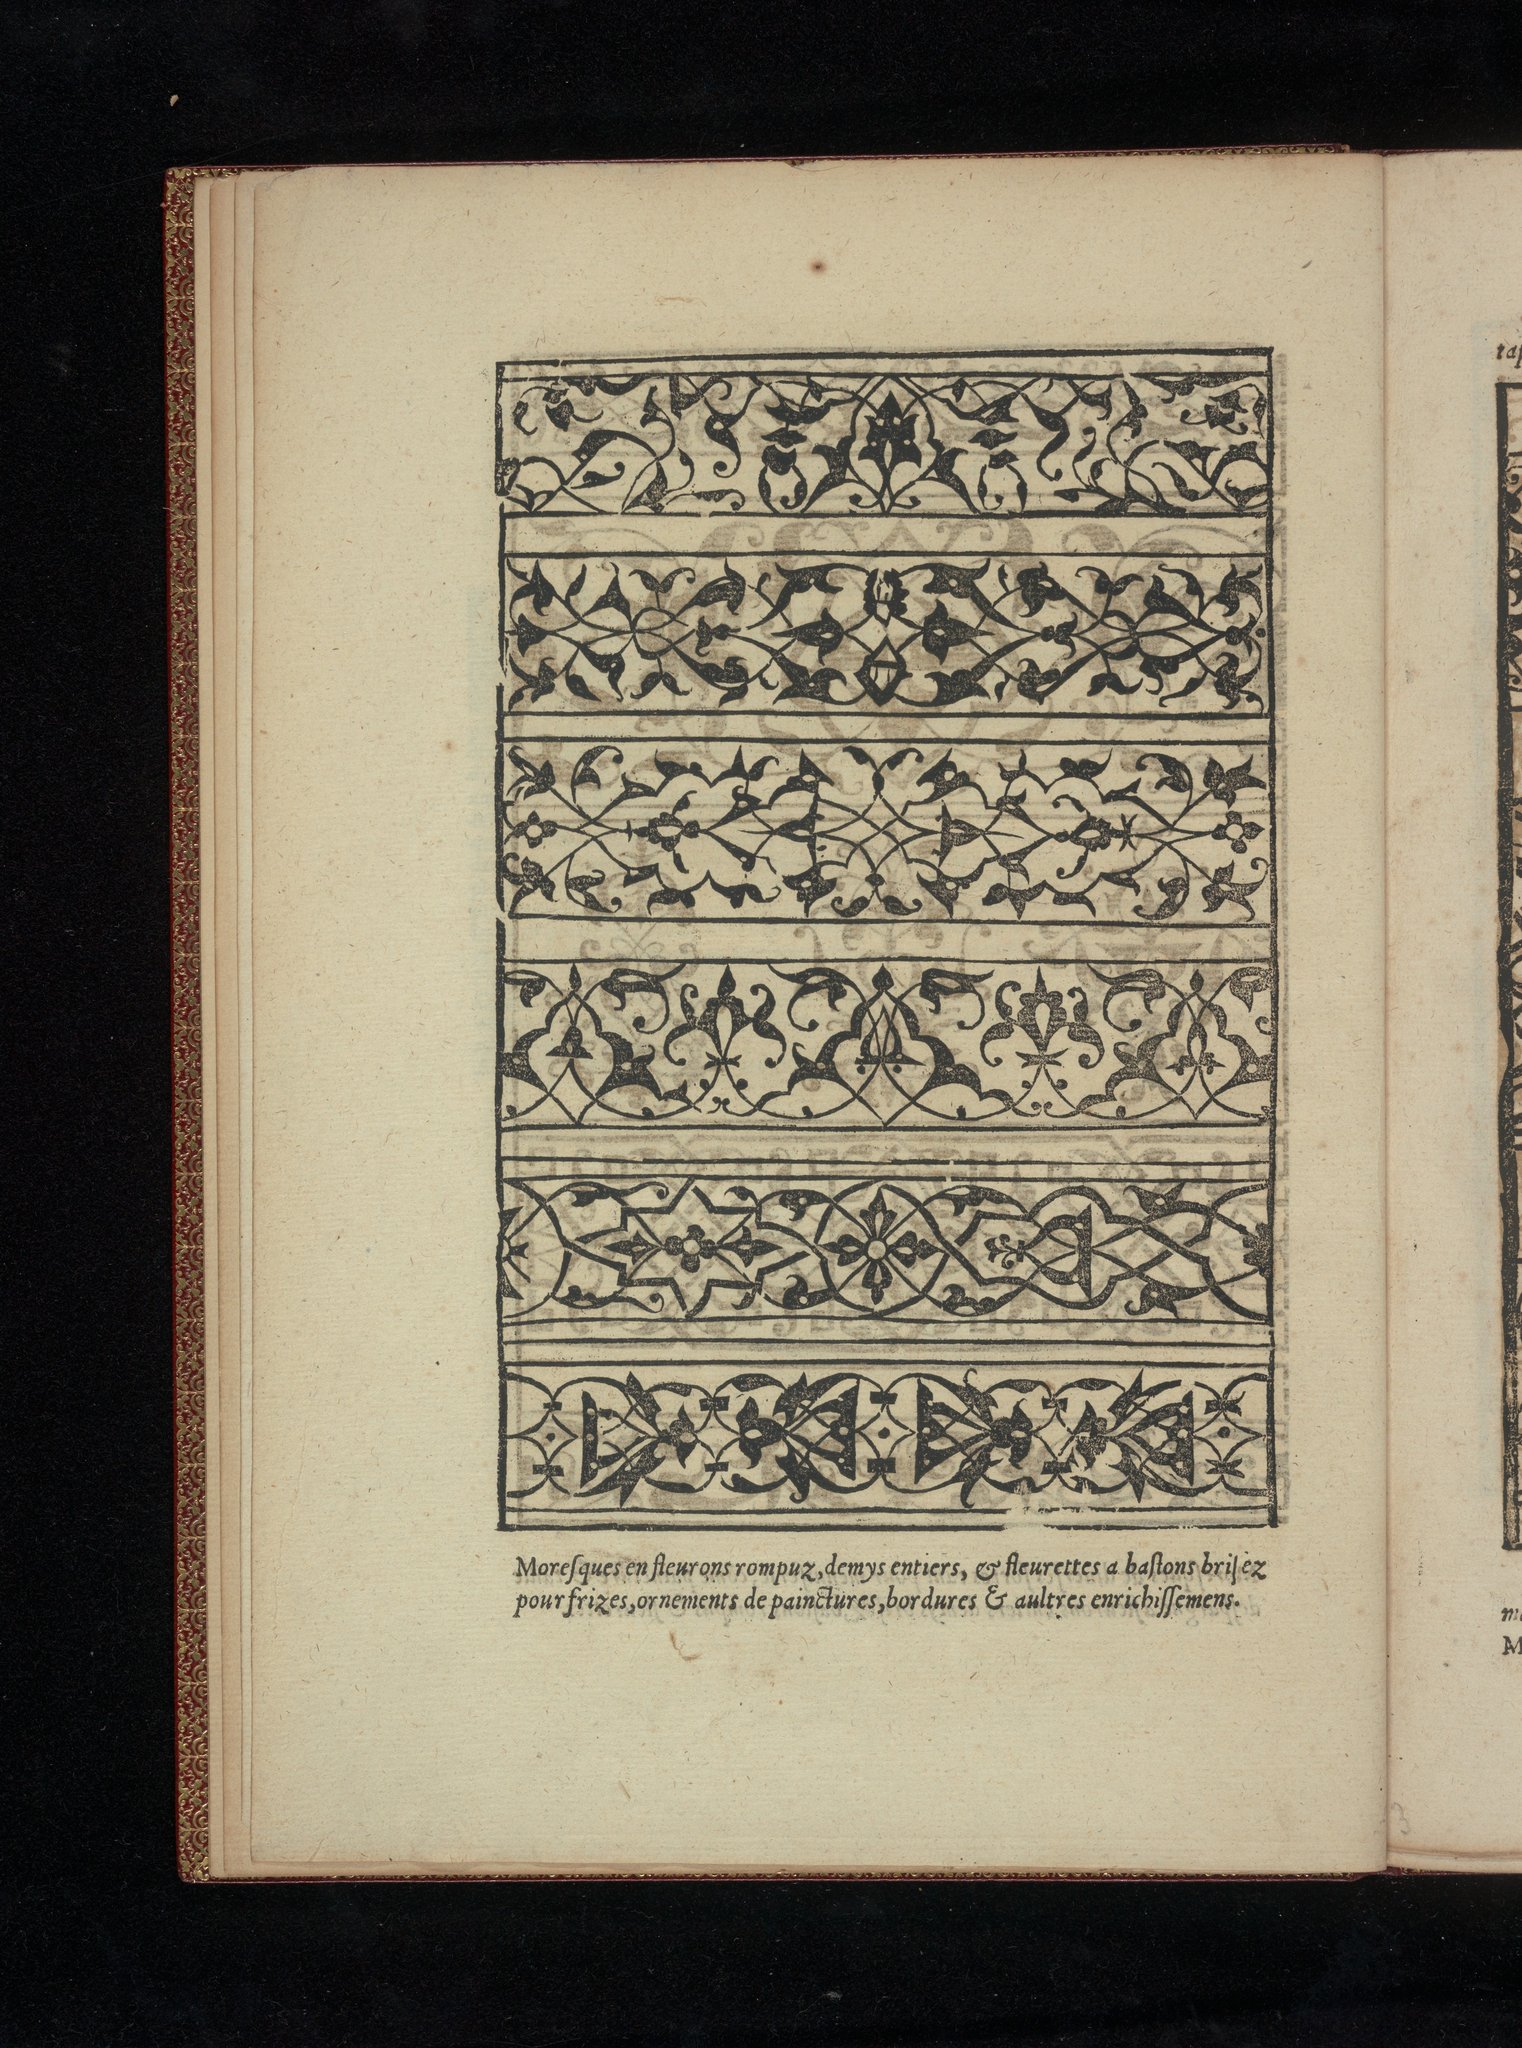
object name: book print ornament architecture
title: Livre de Moresques, page 2 (recto)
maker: francesco di pellegrino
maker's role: artist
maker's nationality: italian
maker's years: 1525-1552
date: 1546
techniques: woodcut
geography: france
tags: ornament